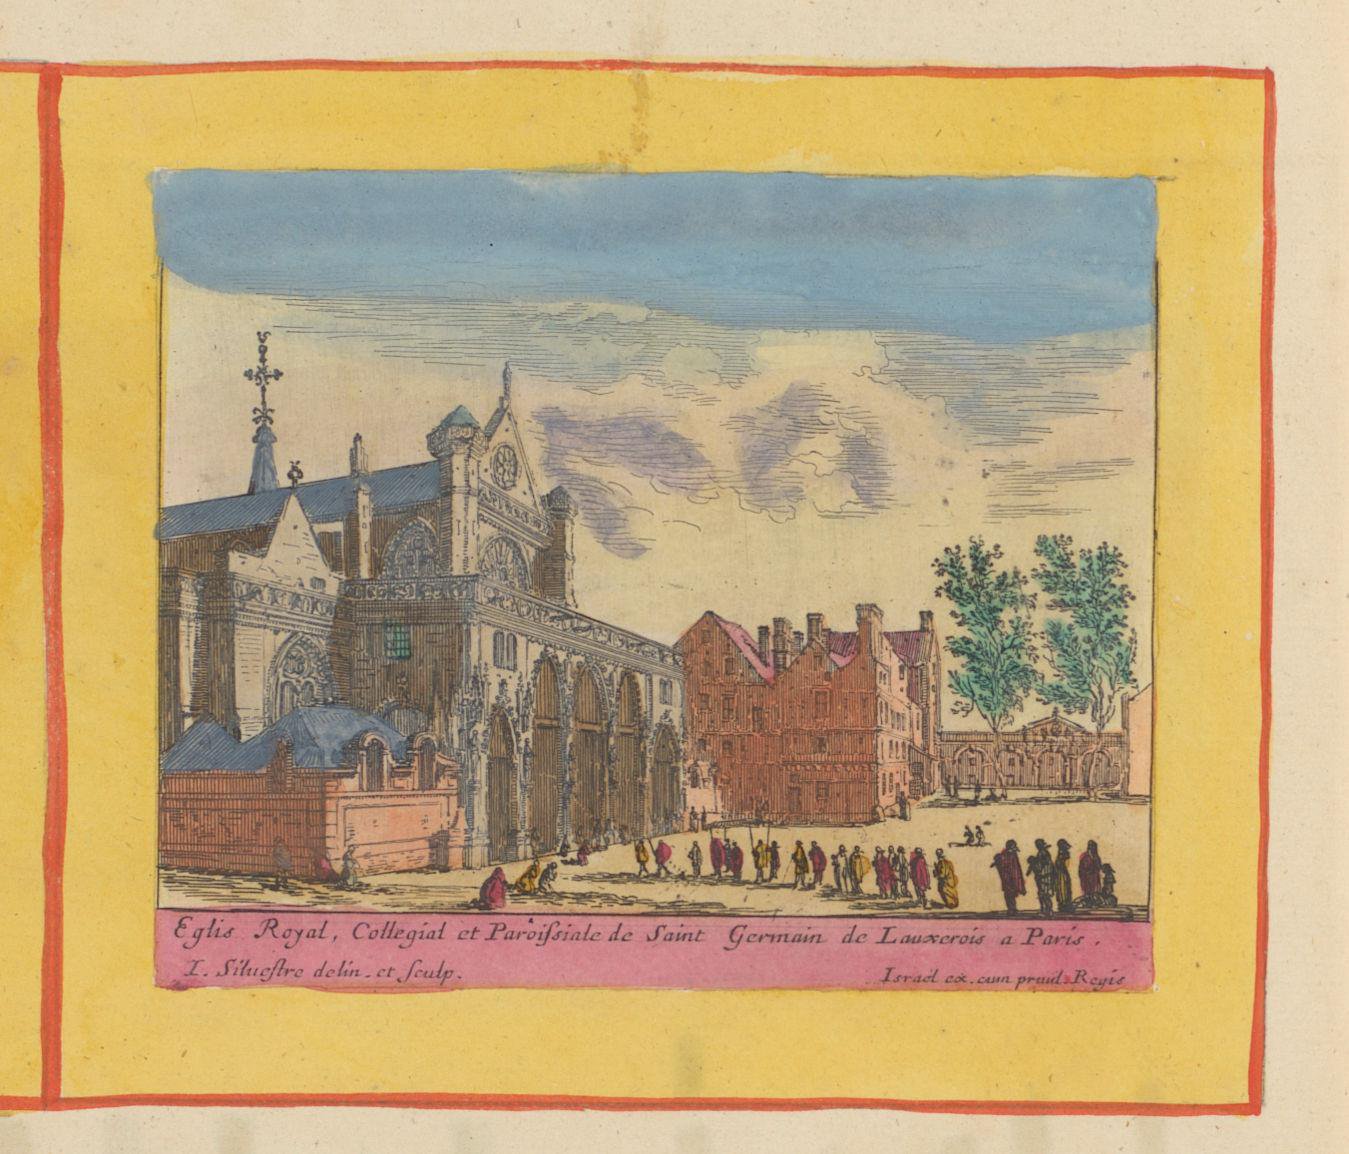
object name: album leaf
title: Eglis Royal, Collegial et Paroissiale de Saint Germain de Lauxerois a Paris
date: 1631-1661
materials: paper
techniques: etching, hand coloring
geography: paris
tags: church (exterior)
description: Gezicht op de kerk van Saint-Germain-l'Auxerrois te Parijs. Prent maakt deel uit van een album.